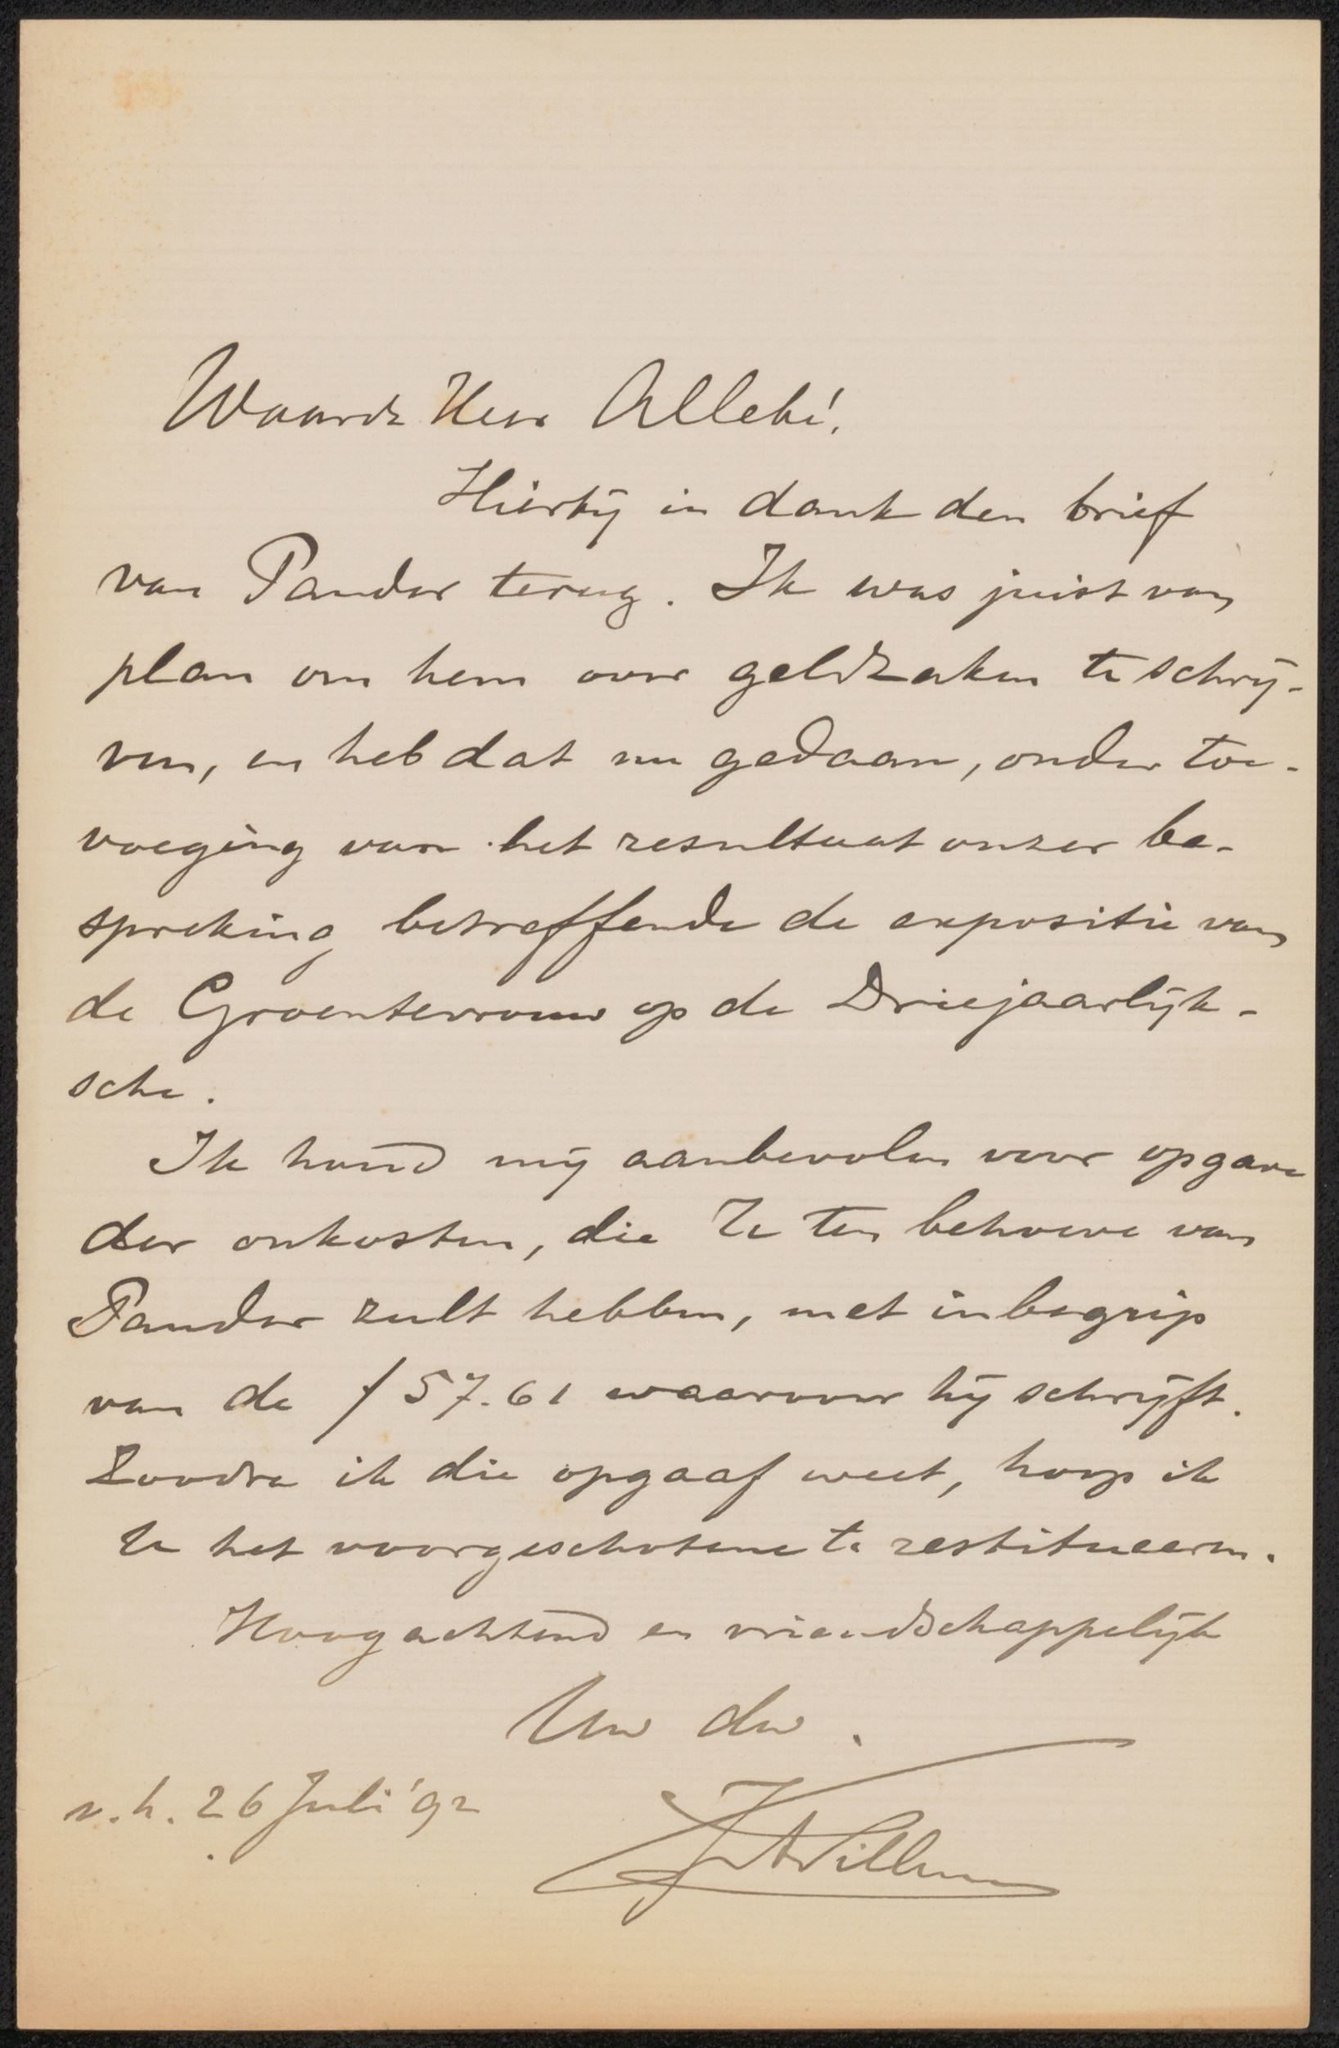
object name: letter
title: Brief aan August Allebé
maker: jérôme alexander sillem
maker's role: politician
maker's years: 1840-1912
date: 1892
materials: ink, paper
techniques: pen, writing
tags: print maker, august allebé, rome, draughtsman, designer, sculptor, pier pander, exhibition ~ art, money